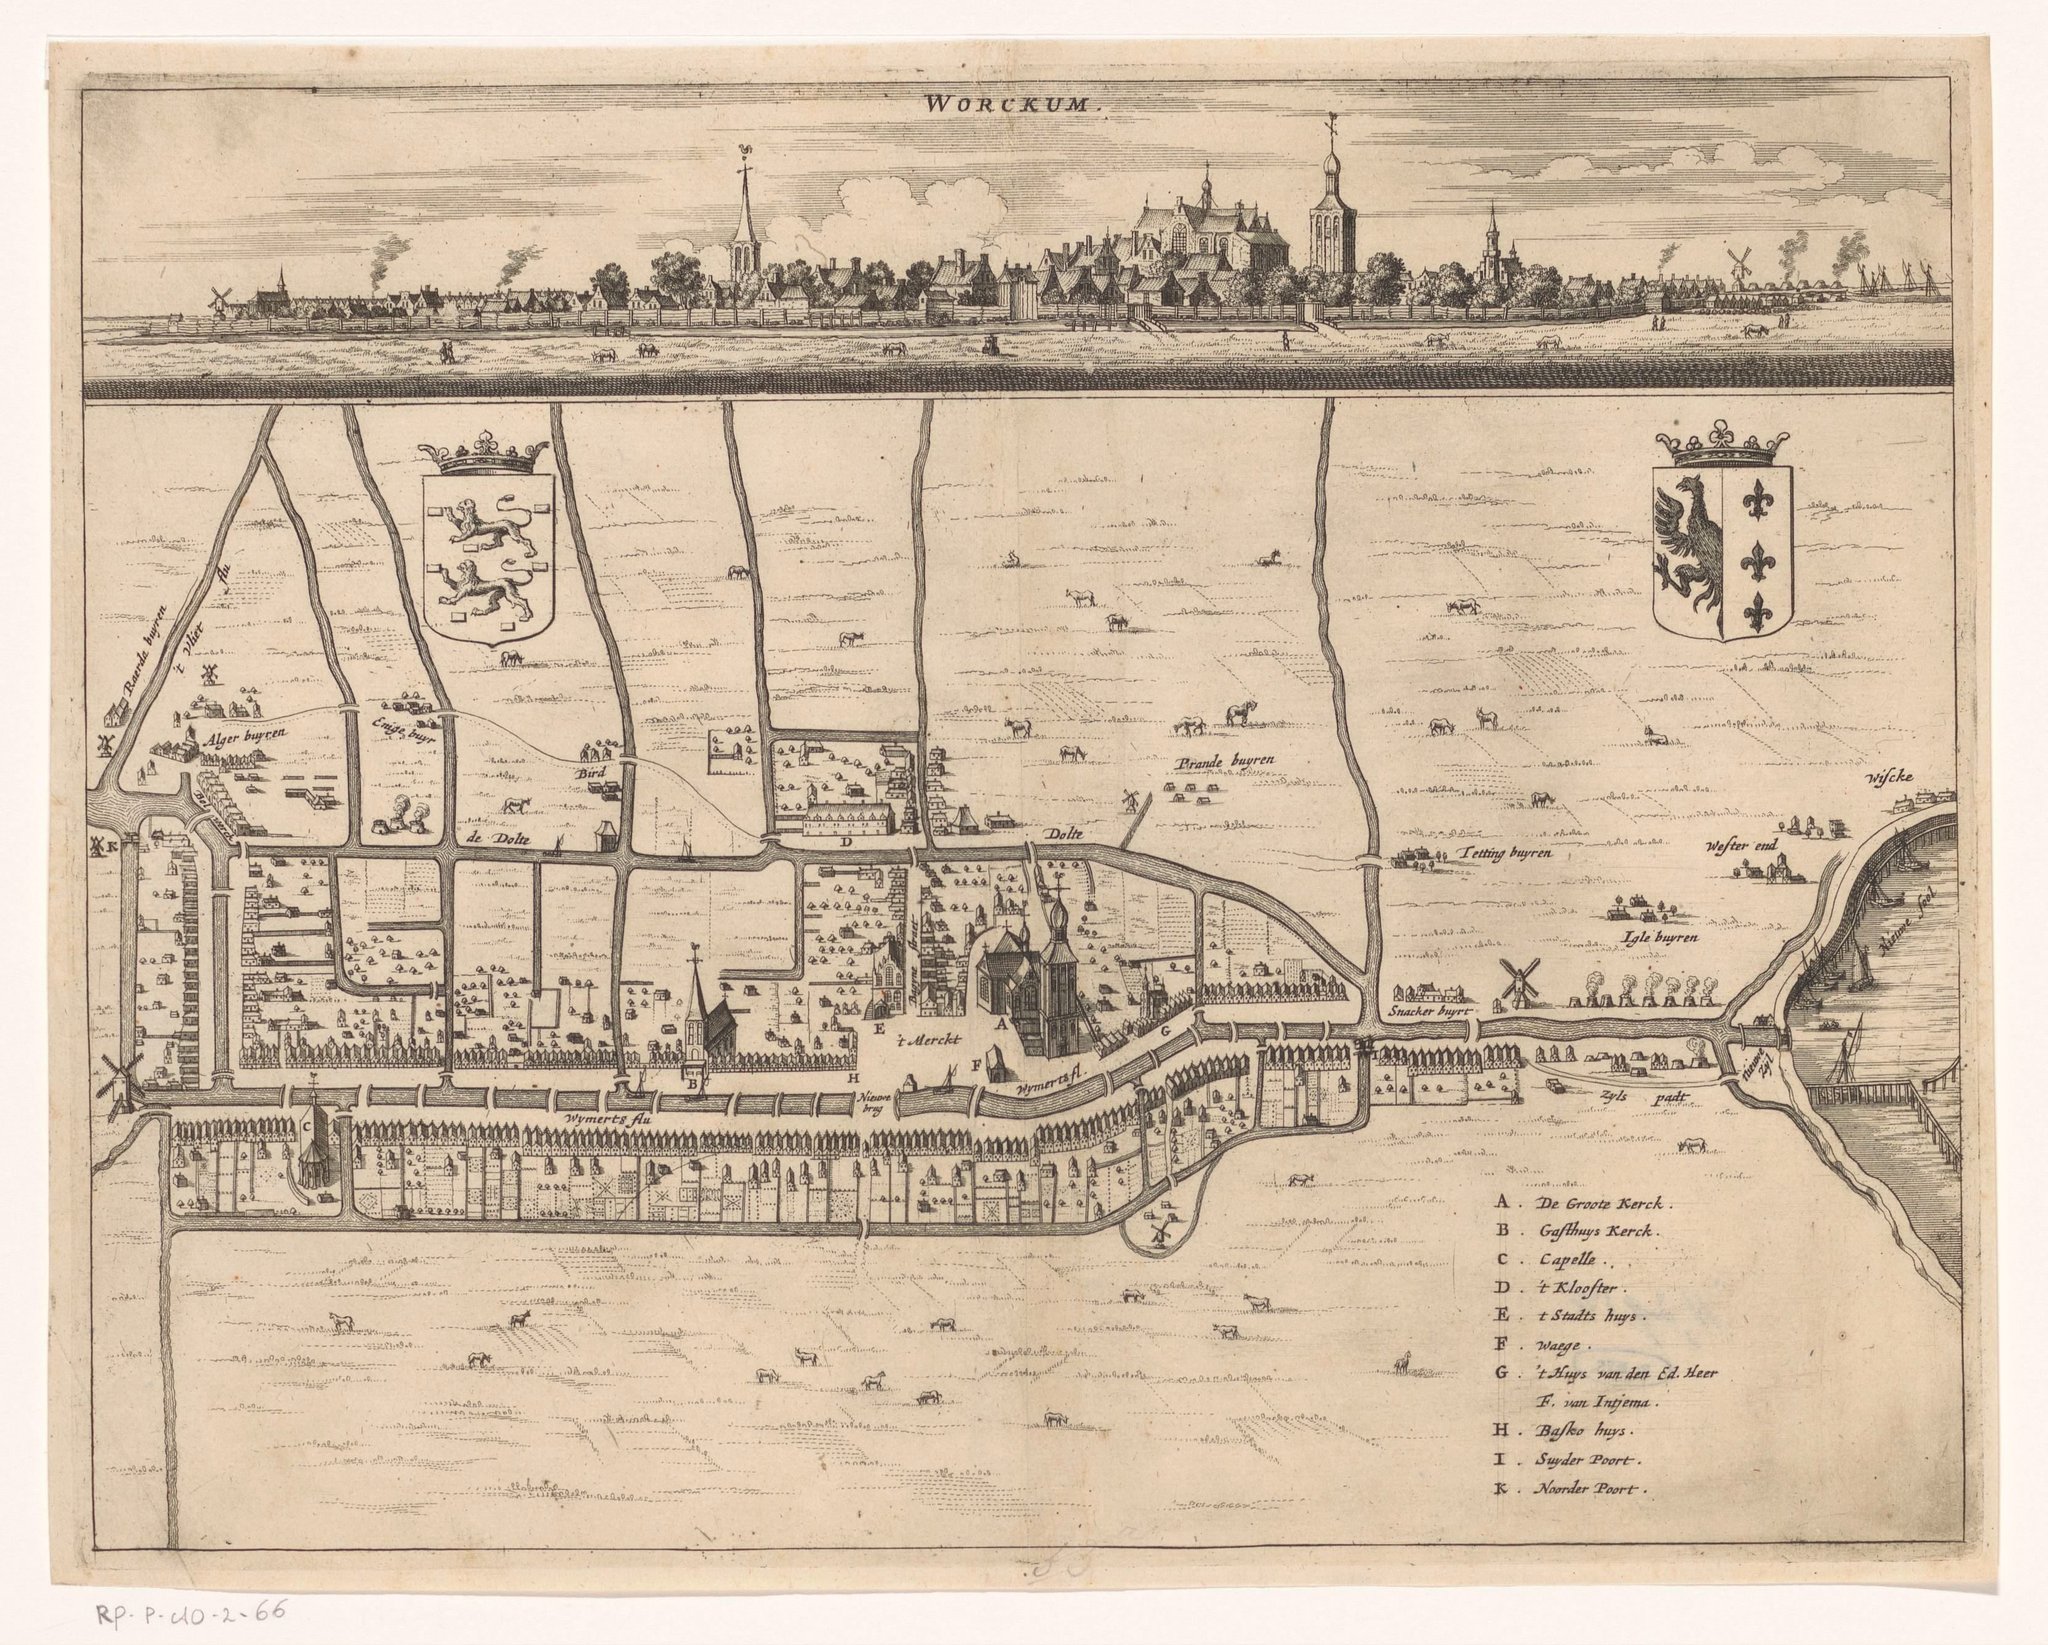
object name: area plan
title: Plattegrond van Workum met stadsgezicht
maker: jacob van meurs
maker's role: draughtsman, print maker, publisher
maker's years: 1619-1680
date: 1664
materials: paper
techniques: engraving, etching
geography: amsterdam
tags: coat of arms (as symbol of the state, etc.), city-view, and landscape with man-made constructions, maps of cities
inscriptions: collector's mark: Lugt 2228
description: Prent ook gebruikt in: Schotanus, Christianus. Beschryvinge van de heerlyckheydt van Frieslandt tusschen 't Flie end de Lauwers (...). Franeker: Johannes Wellens, 1664.